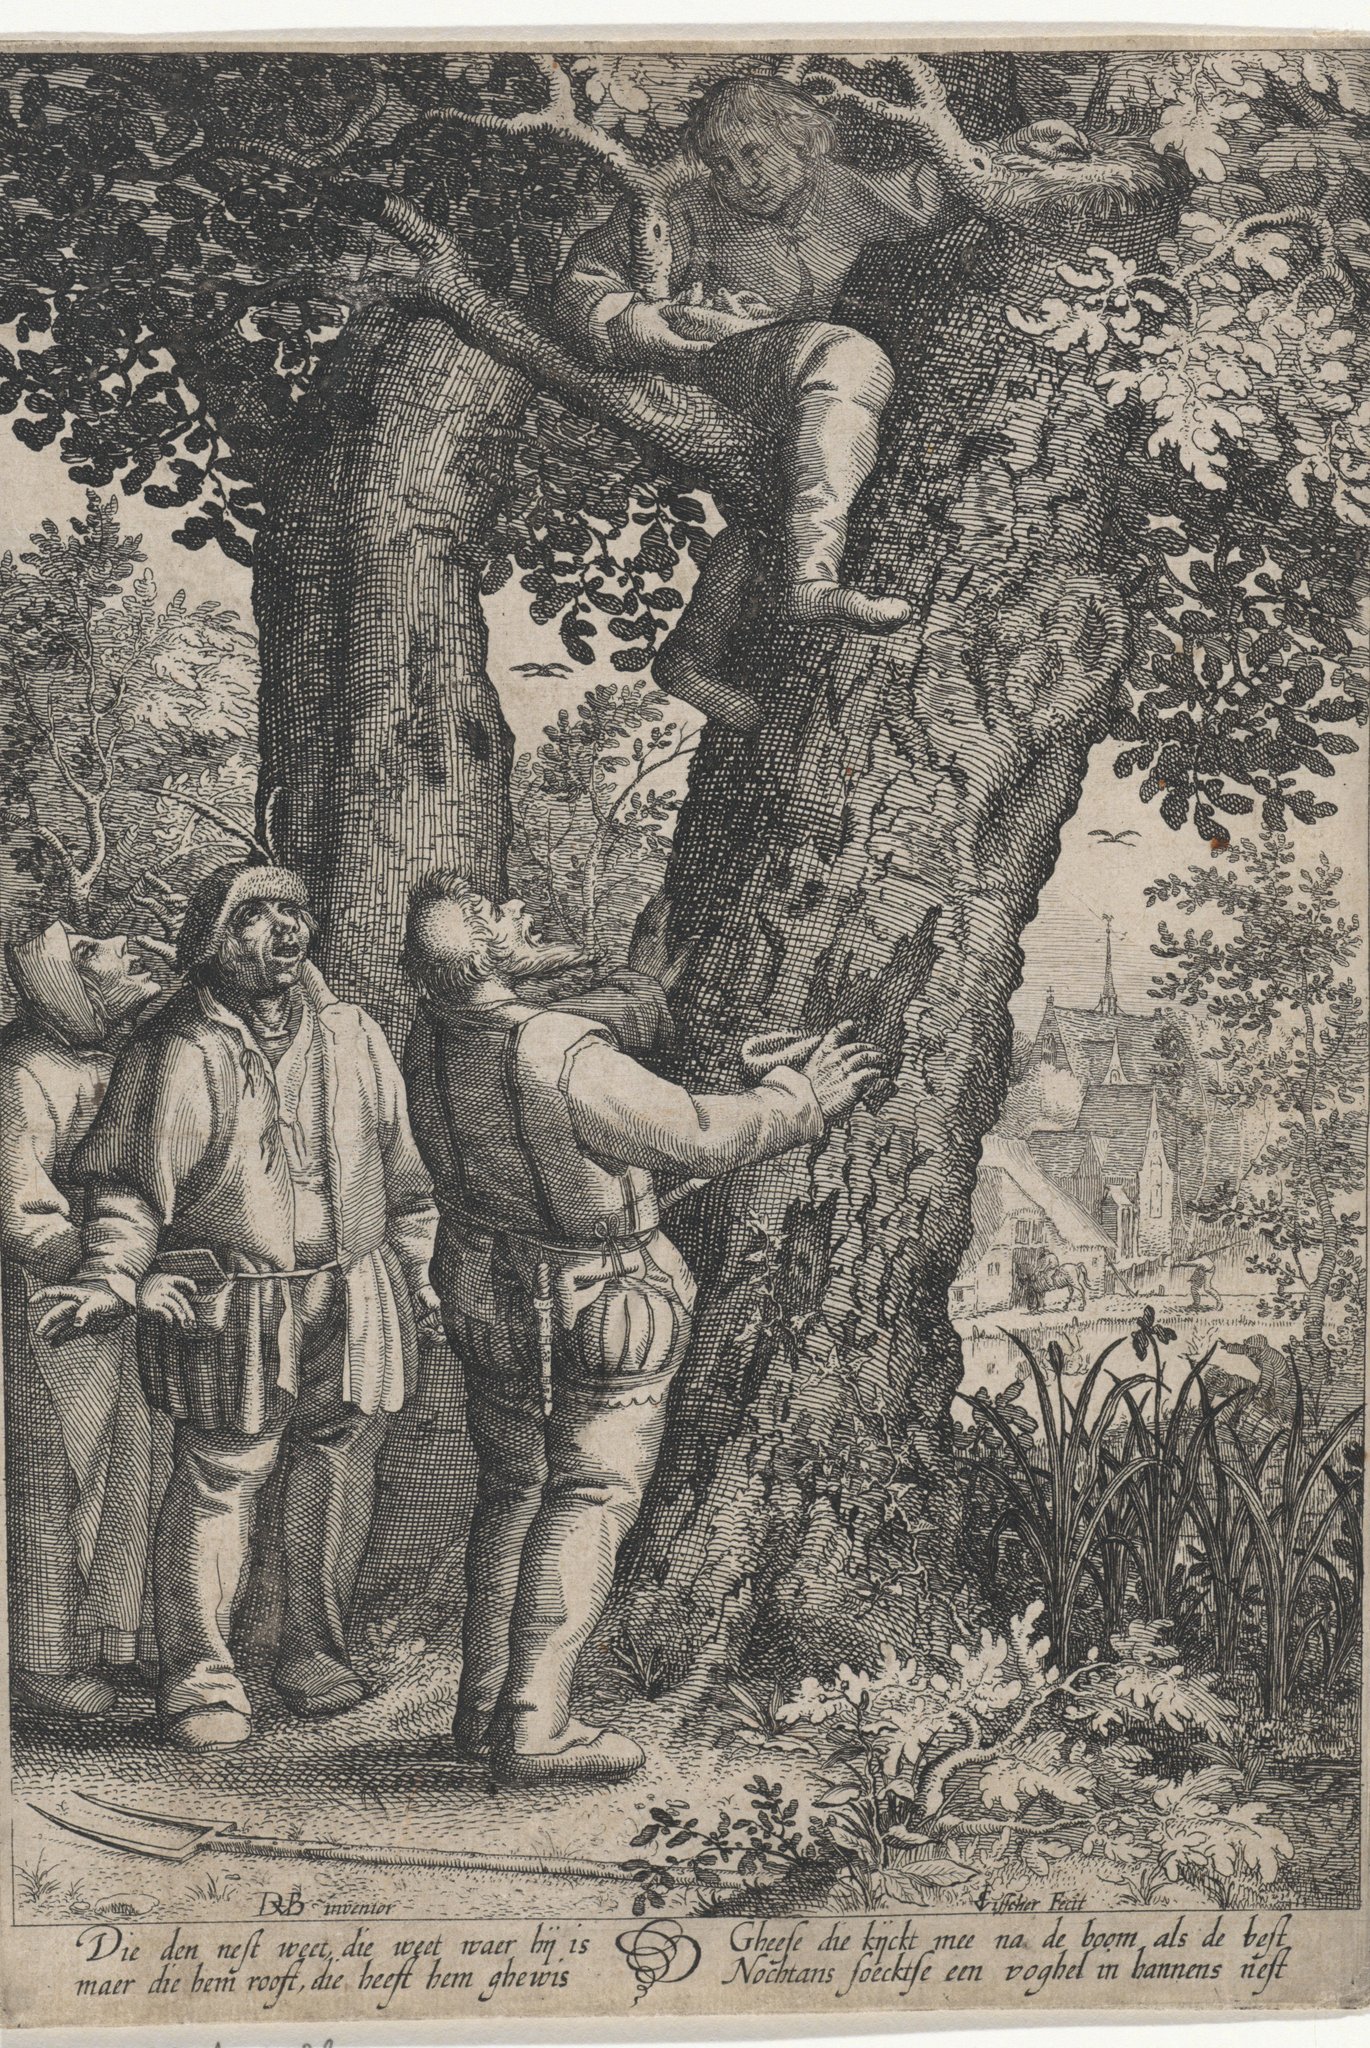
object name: print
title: Vogelnestrover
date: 1596-1630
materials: paper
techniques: etching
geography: amsterdam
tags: child robbing bird's nests, proverbs, sayings, etc.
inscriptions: caption: ‘Die den nest weet...hannans nest’, signature: ‘DvB inventor’, collector's mark: Lugt 2228, signature: ‘CIVisscher Fecit’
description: Een jongen zit in een boom en haalt daar een vogelnest uit. Hij heeft het nest met de vogels in zijn hand. Onder de boom staan drie mannen te roepen. Een jongen zit in een boom en haalt daar een vogelnest uit. Hij heeft het nest met de vogels in zijn hand. Onder de boom staan drie mannen te roepen. Verbeelding van het spreekwoord ‘Die het nest weet, die weet het, maar die het rooft, die heeft het'.